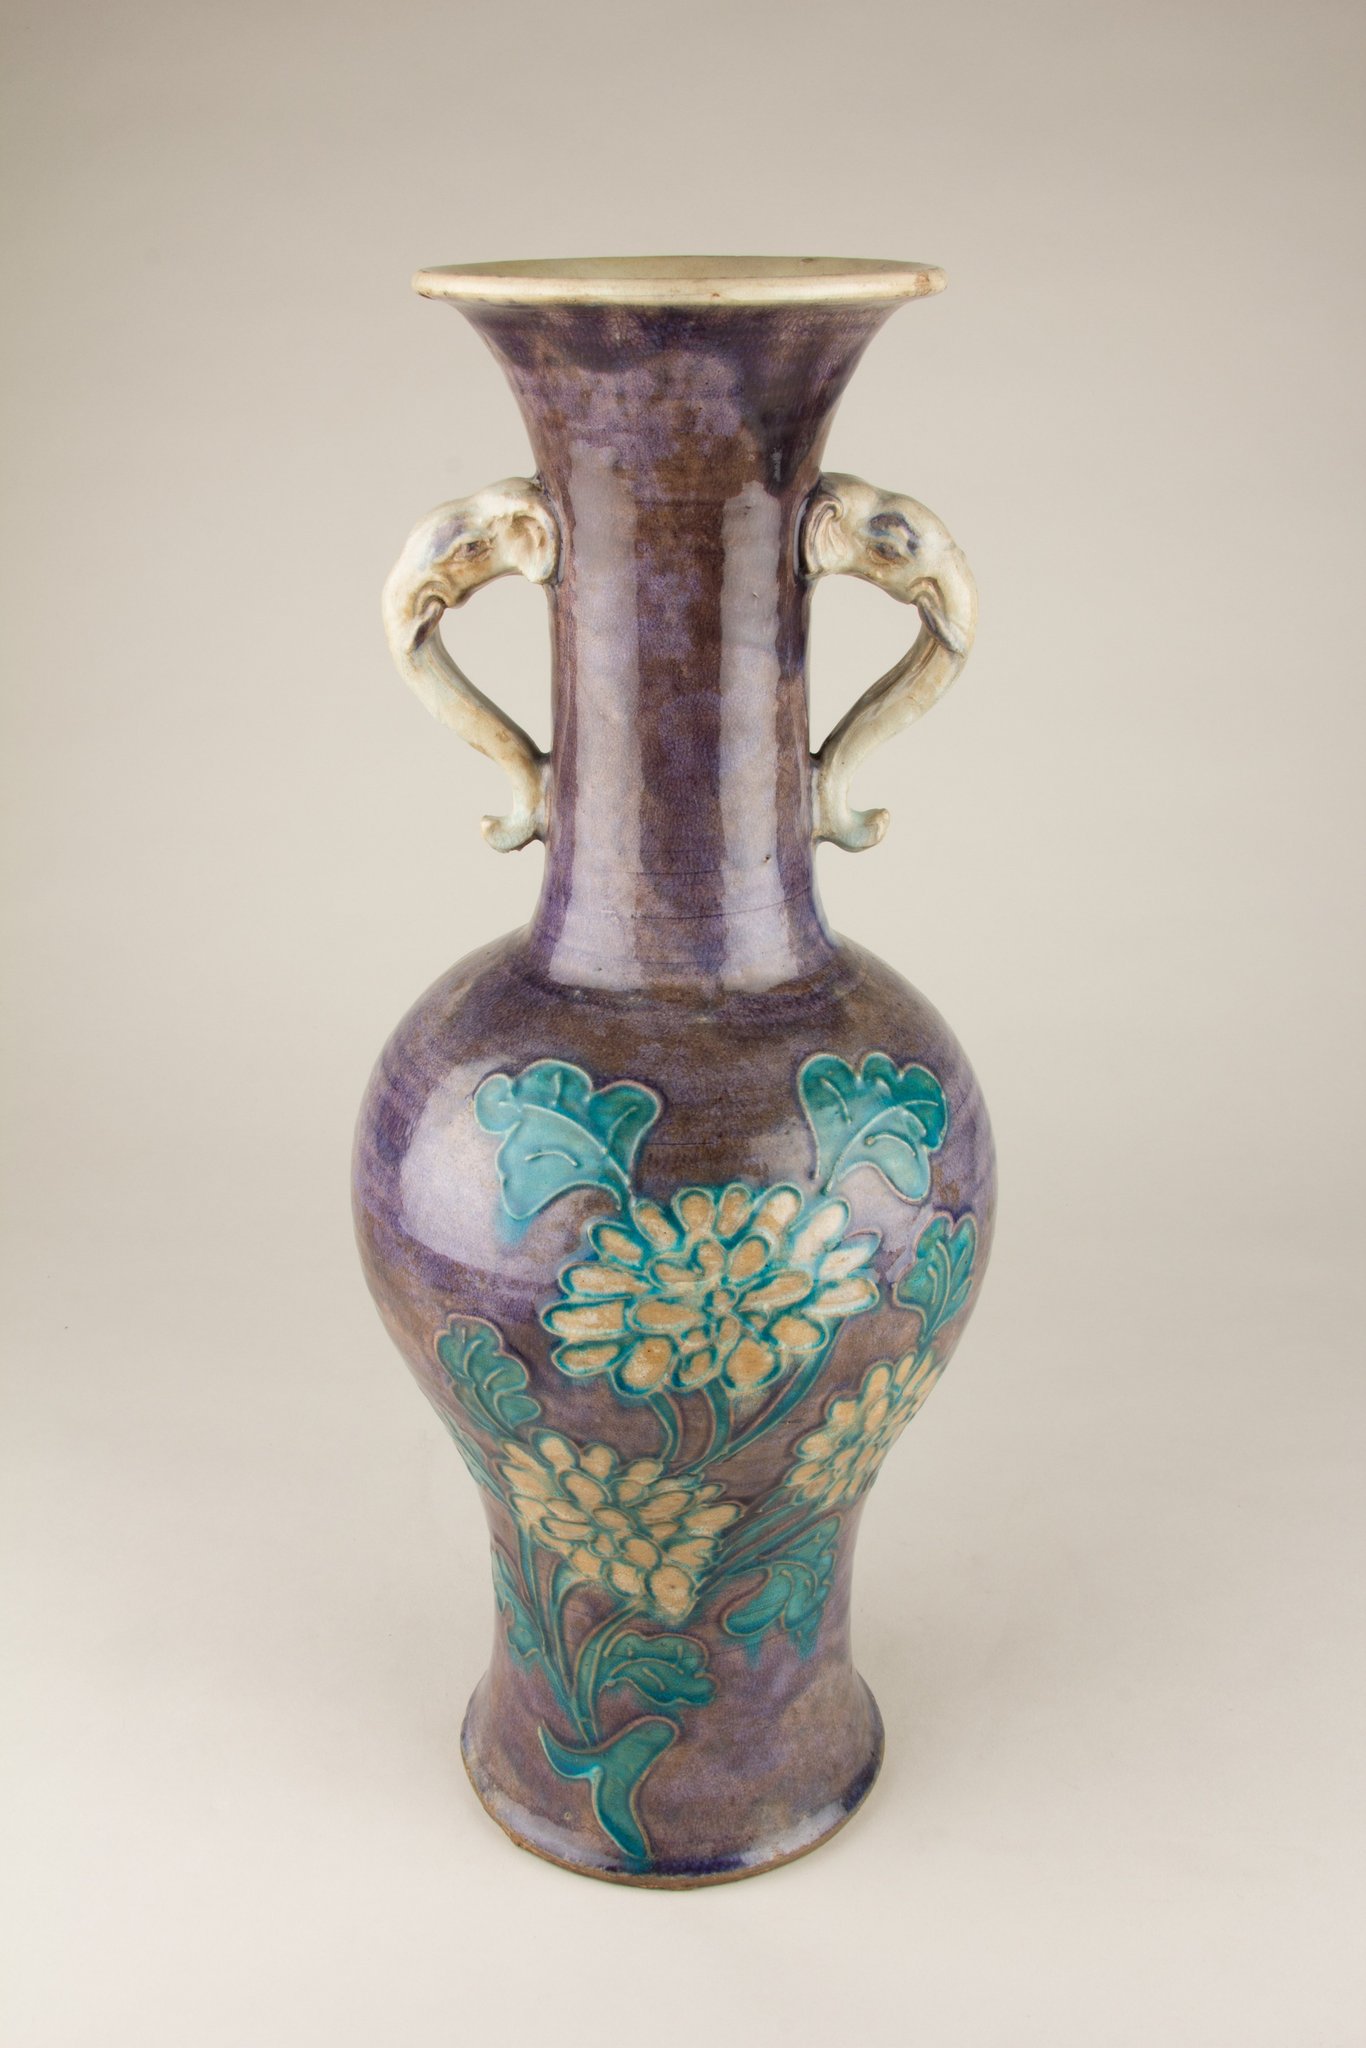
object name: vase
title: Vase with elephant head handles and floral decoration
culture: chinese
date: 1501-1600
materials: glaze, stoneware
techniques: polychrome, relief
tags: elephants,flowers,leaves